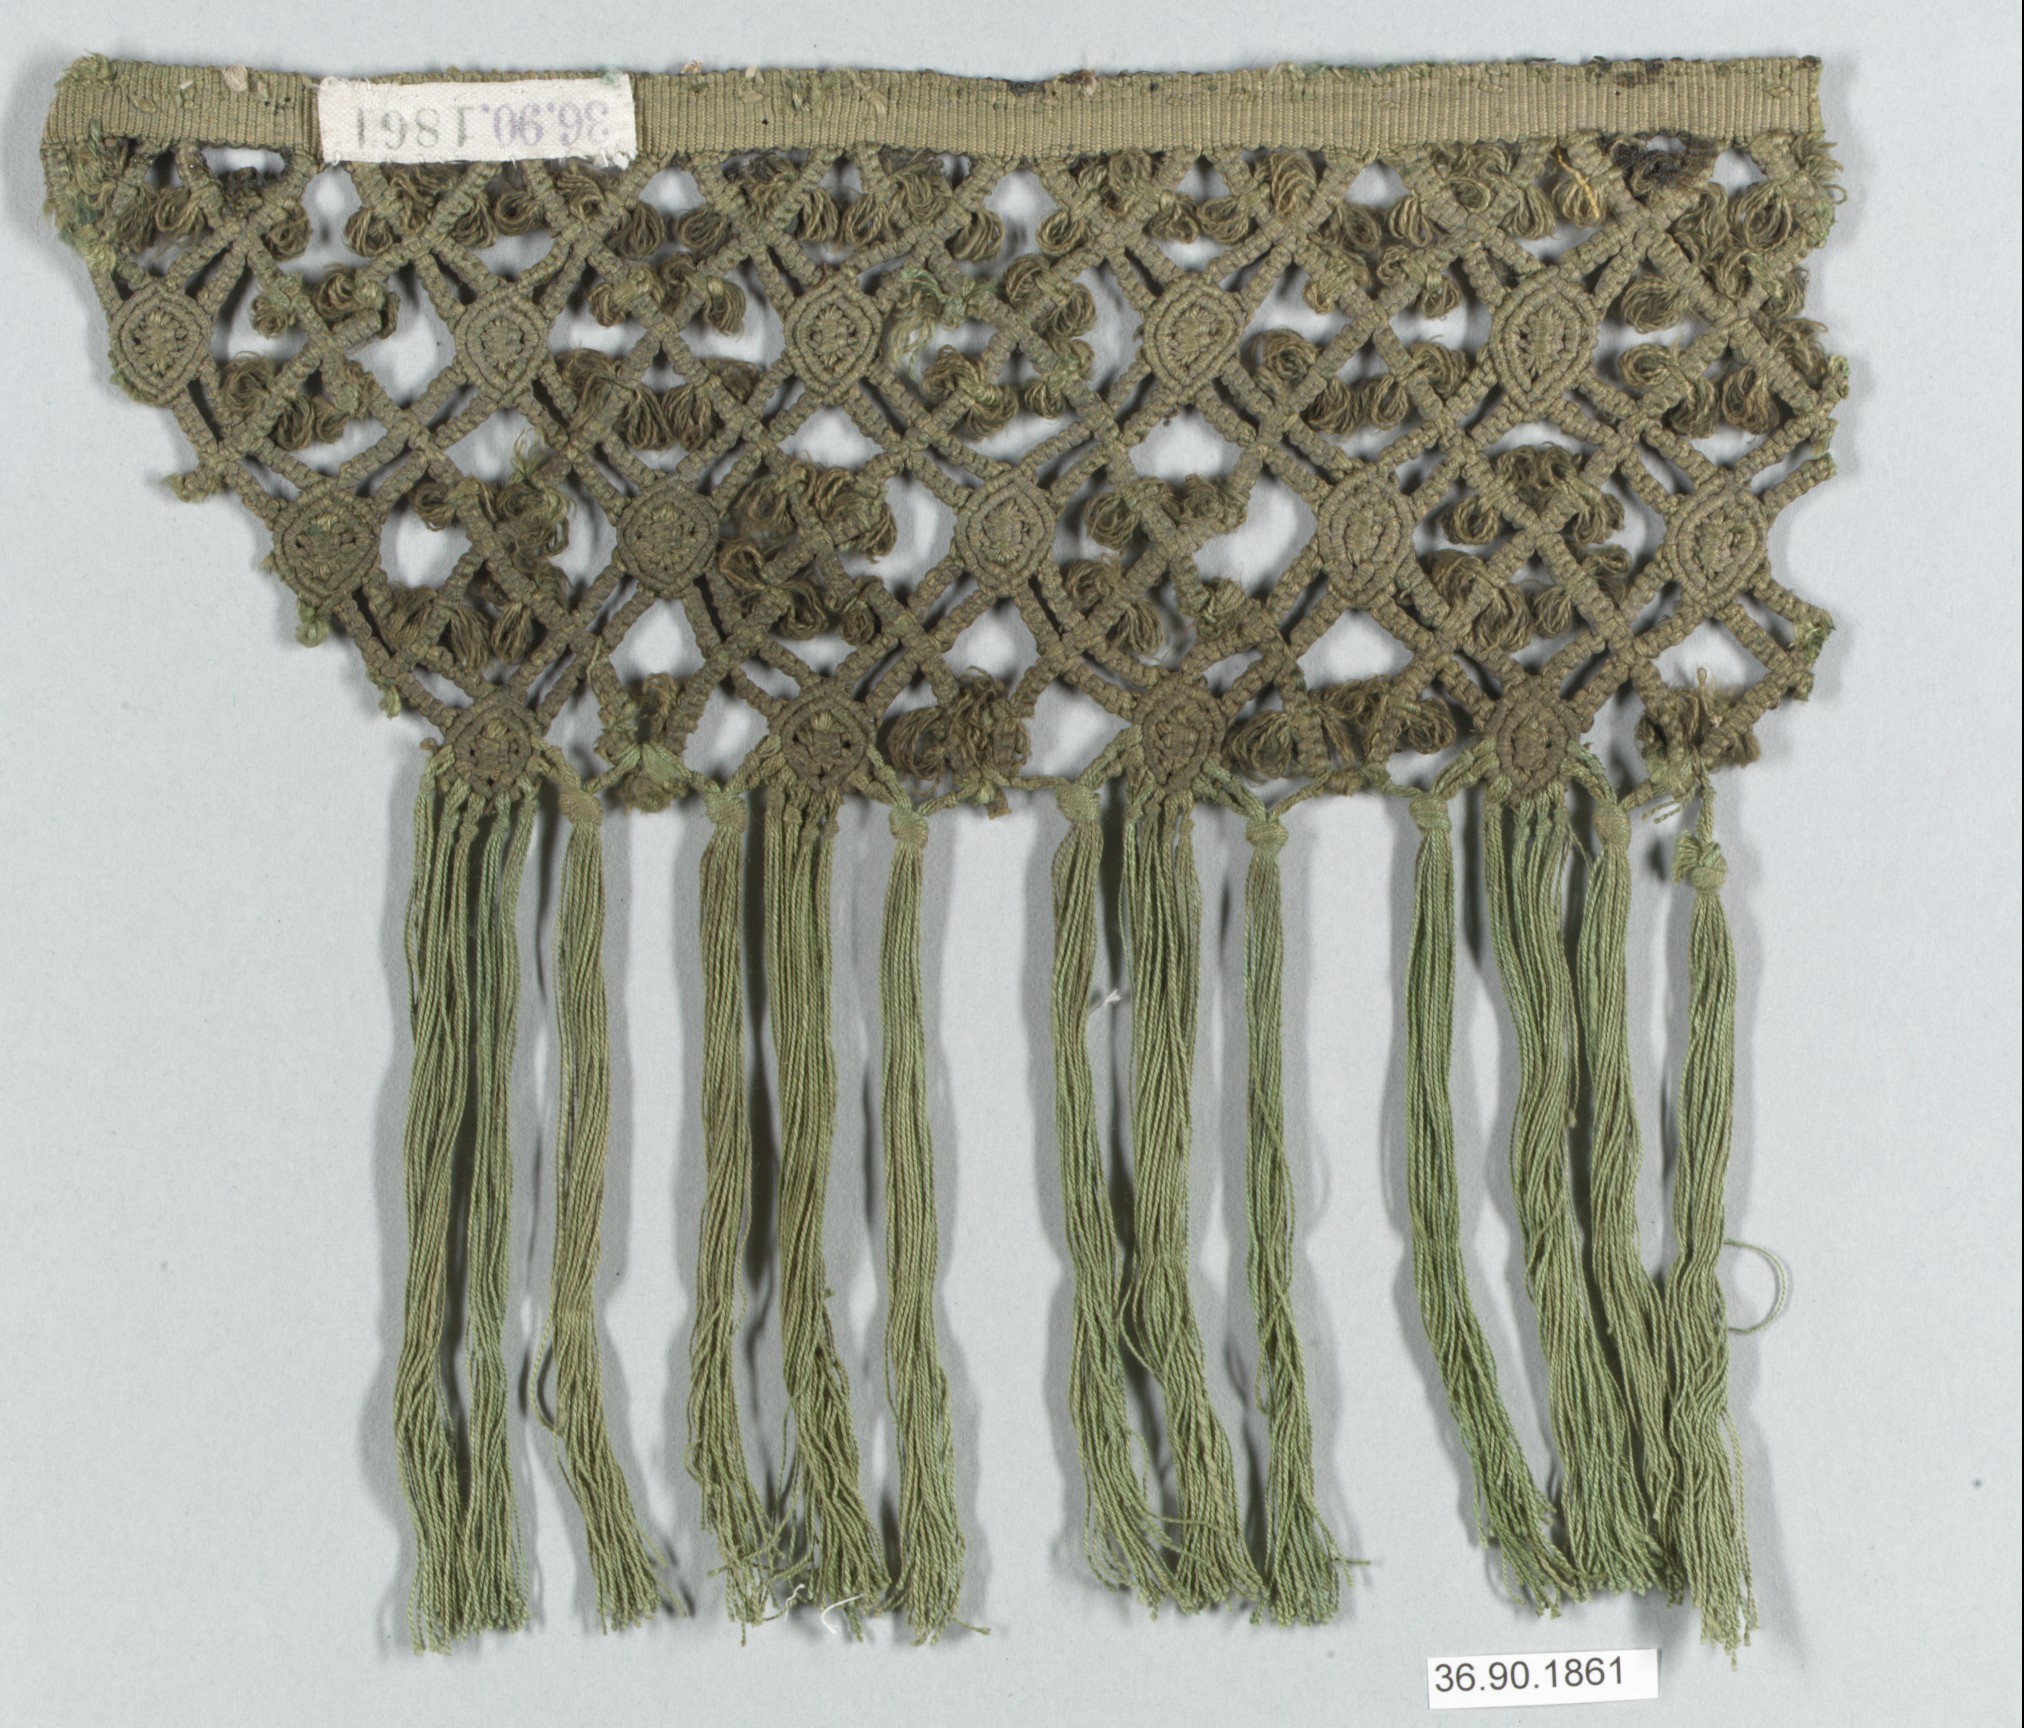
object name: fringe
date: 1801-1900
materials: silk